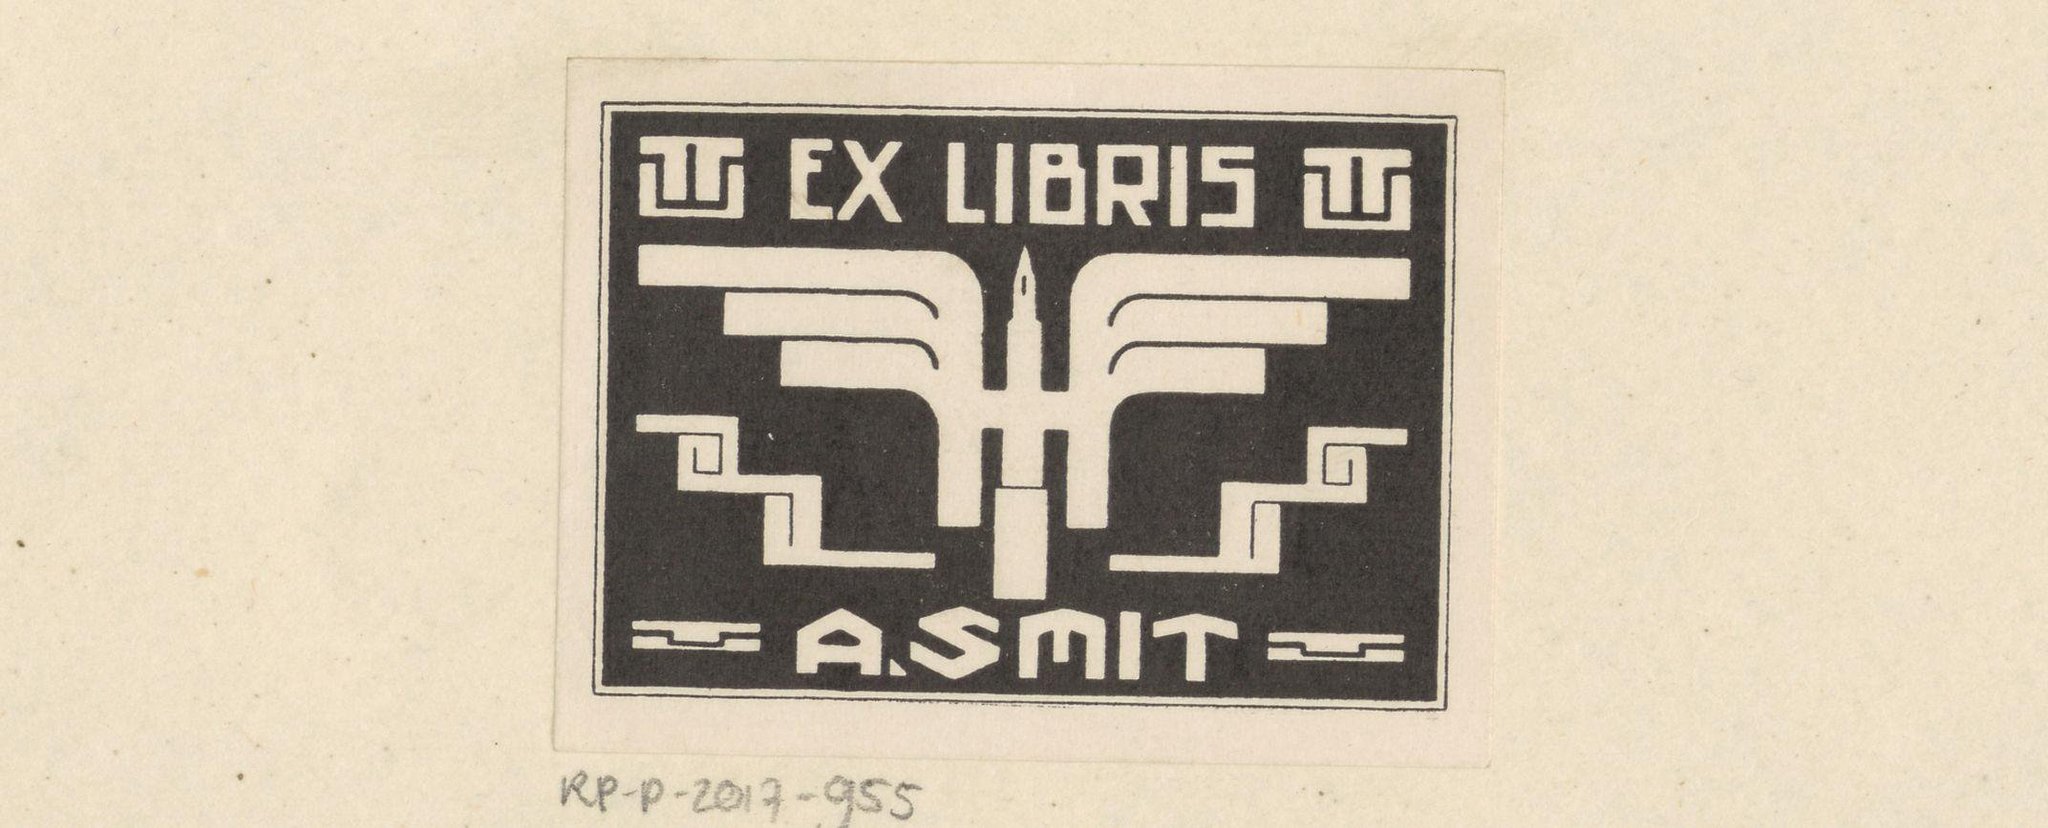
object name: bookplate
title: Ex libris van A. Smit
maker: Anonymous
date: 1900-1999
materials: paper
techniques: printing block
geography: netherlands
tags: pen